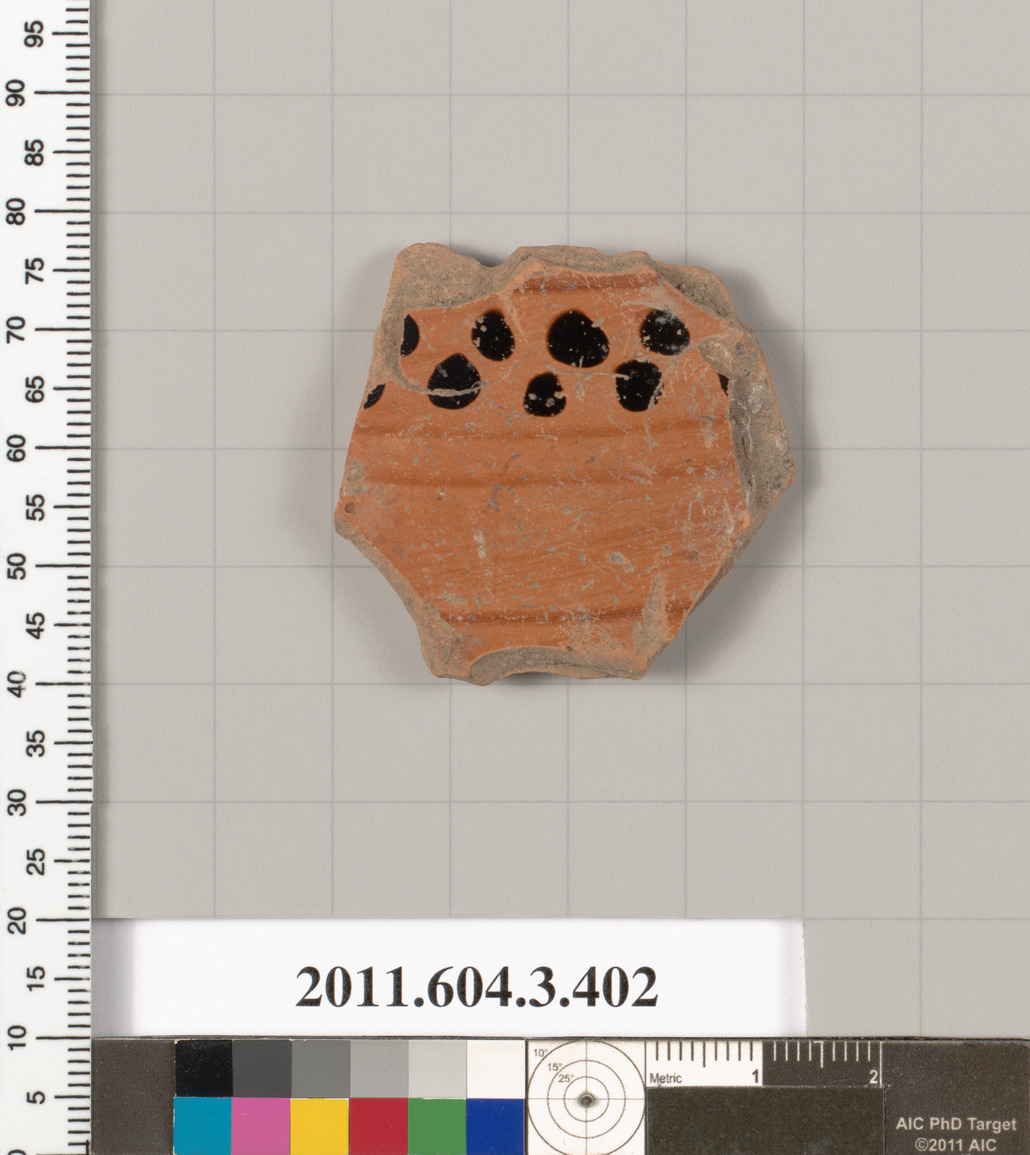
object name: neck amphora fragment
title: Terracotta fragment of a neck-amphora (jar)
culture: greek, attic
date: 534-468 BCE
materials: terracotta